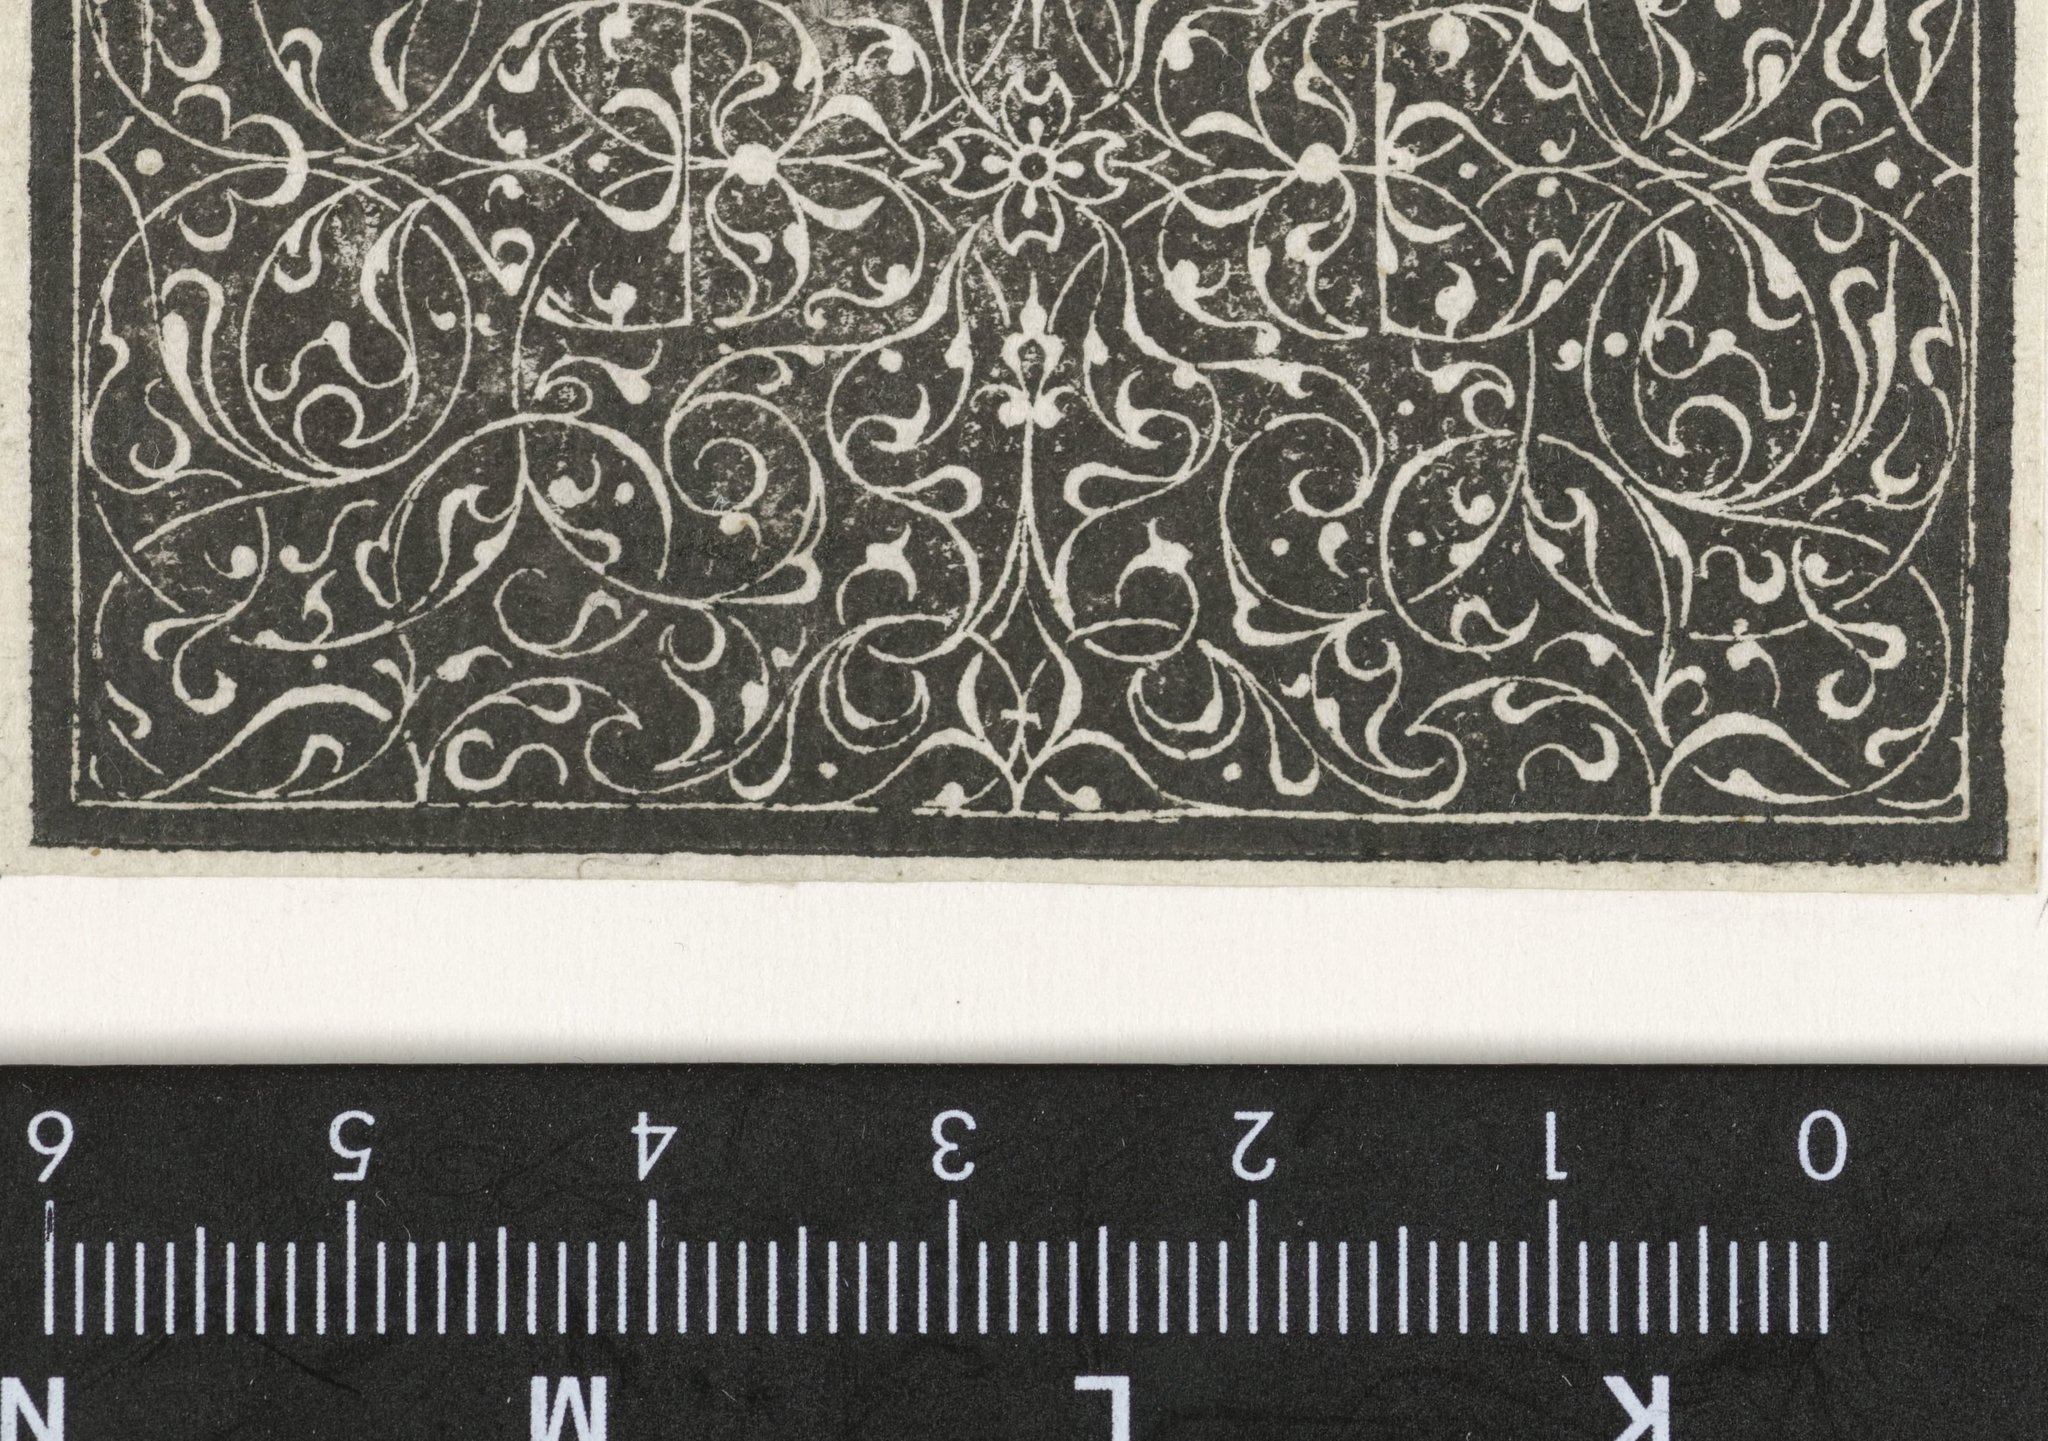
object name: print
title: Arabesken met in het midden een vierbladig bloemetje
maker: Anonymous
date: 1516-1571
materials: paper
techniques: woodcut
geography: france